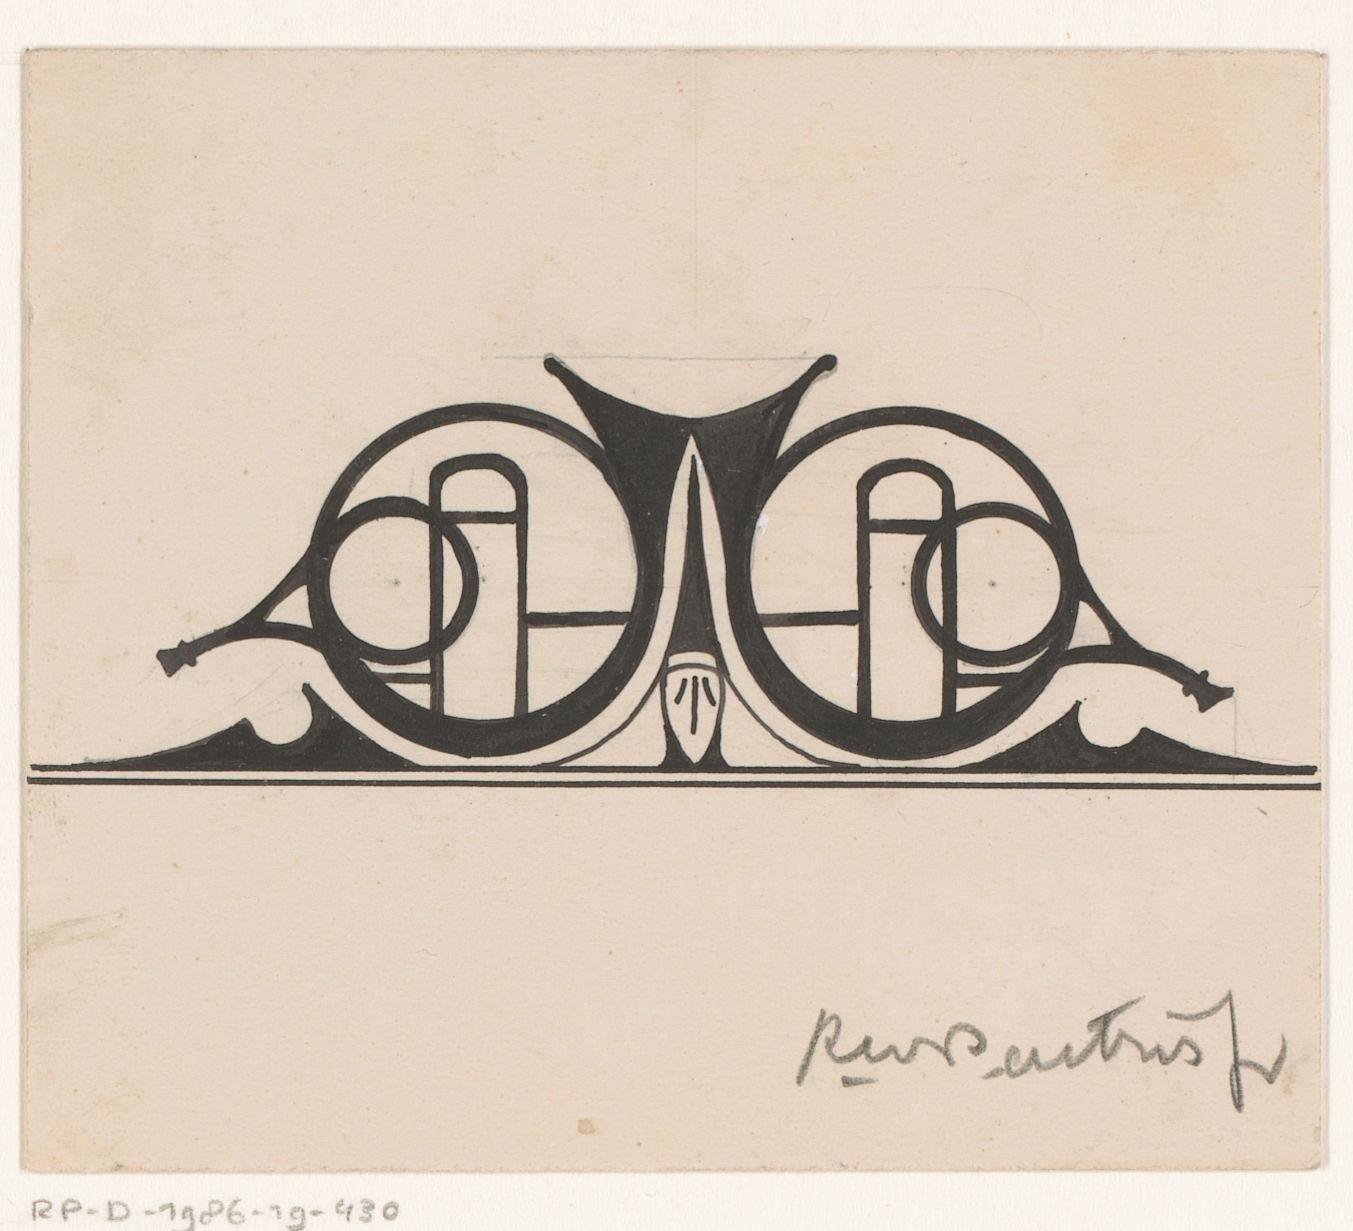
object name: drawing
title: Ontwerp voor een sluitvignet met blaasinstrumenten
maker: reinier willem petrus de vries (1874-1953)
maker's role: draughtsman, print maker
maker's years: 1874-1953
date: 1897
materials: ink, paper, pencil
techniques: brush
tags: horn, trumpet, cornet, trombone, tuba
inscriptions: collector's mark: ‘R:MVS.’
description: Sluitvignet bedoeld voor het muziekstuk 'Klavierstukje' in: Woord en Beeld. Geïllustreerd maandschrift, augustus 1897.